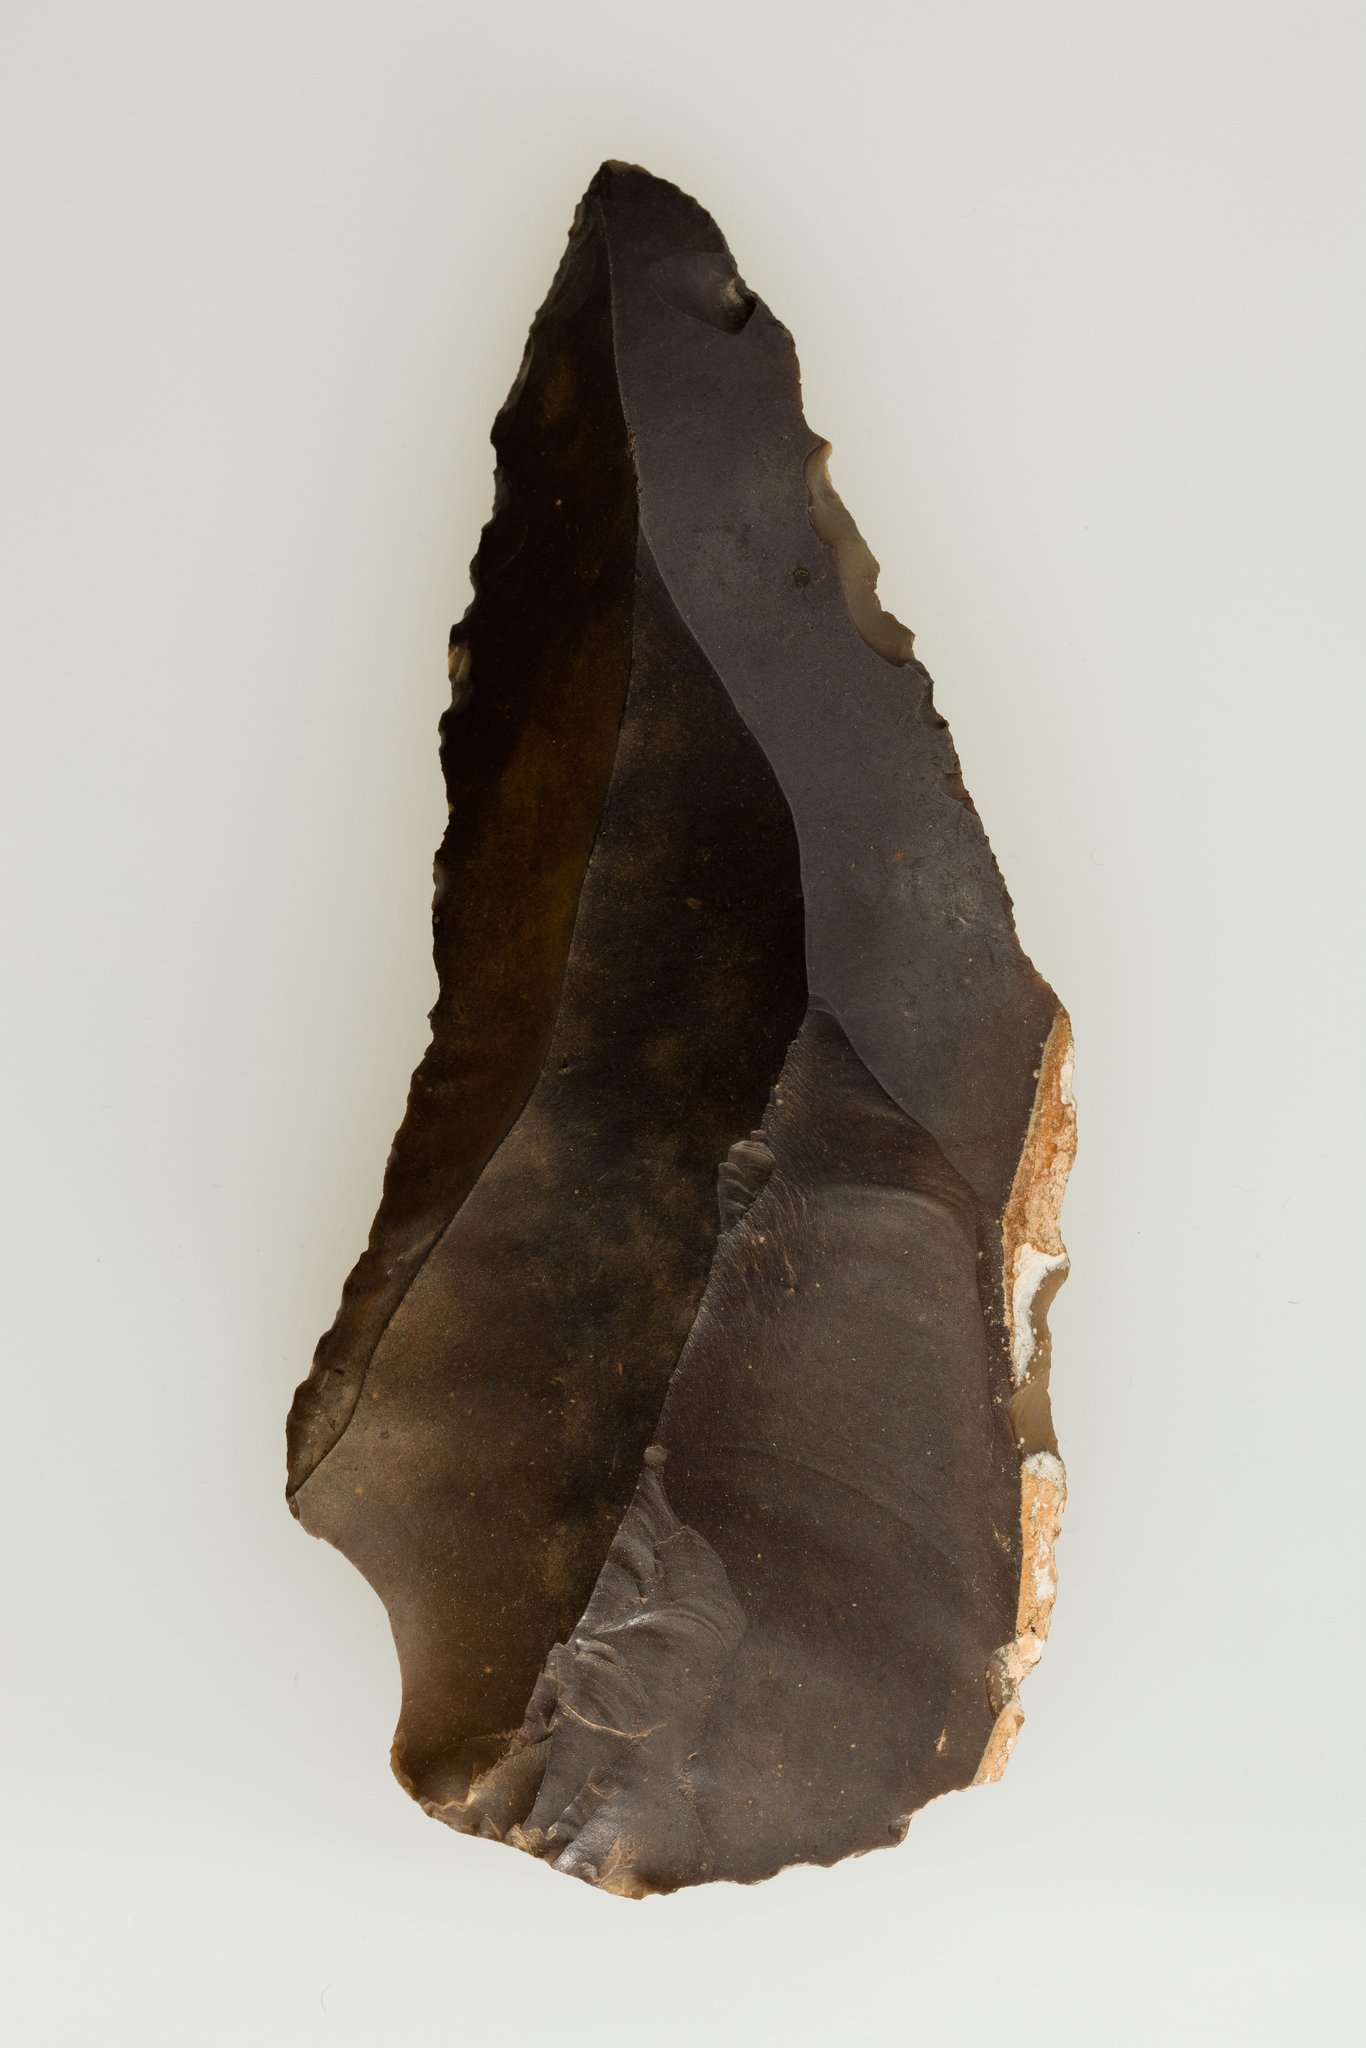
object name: tool, point, levallois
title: Atypical Levallois Point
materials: stone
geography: egypt